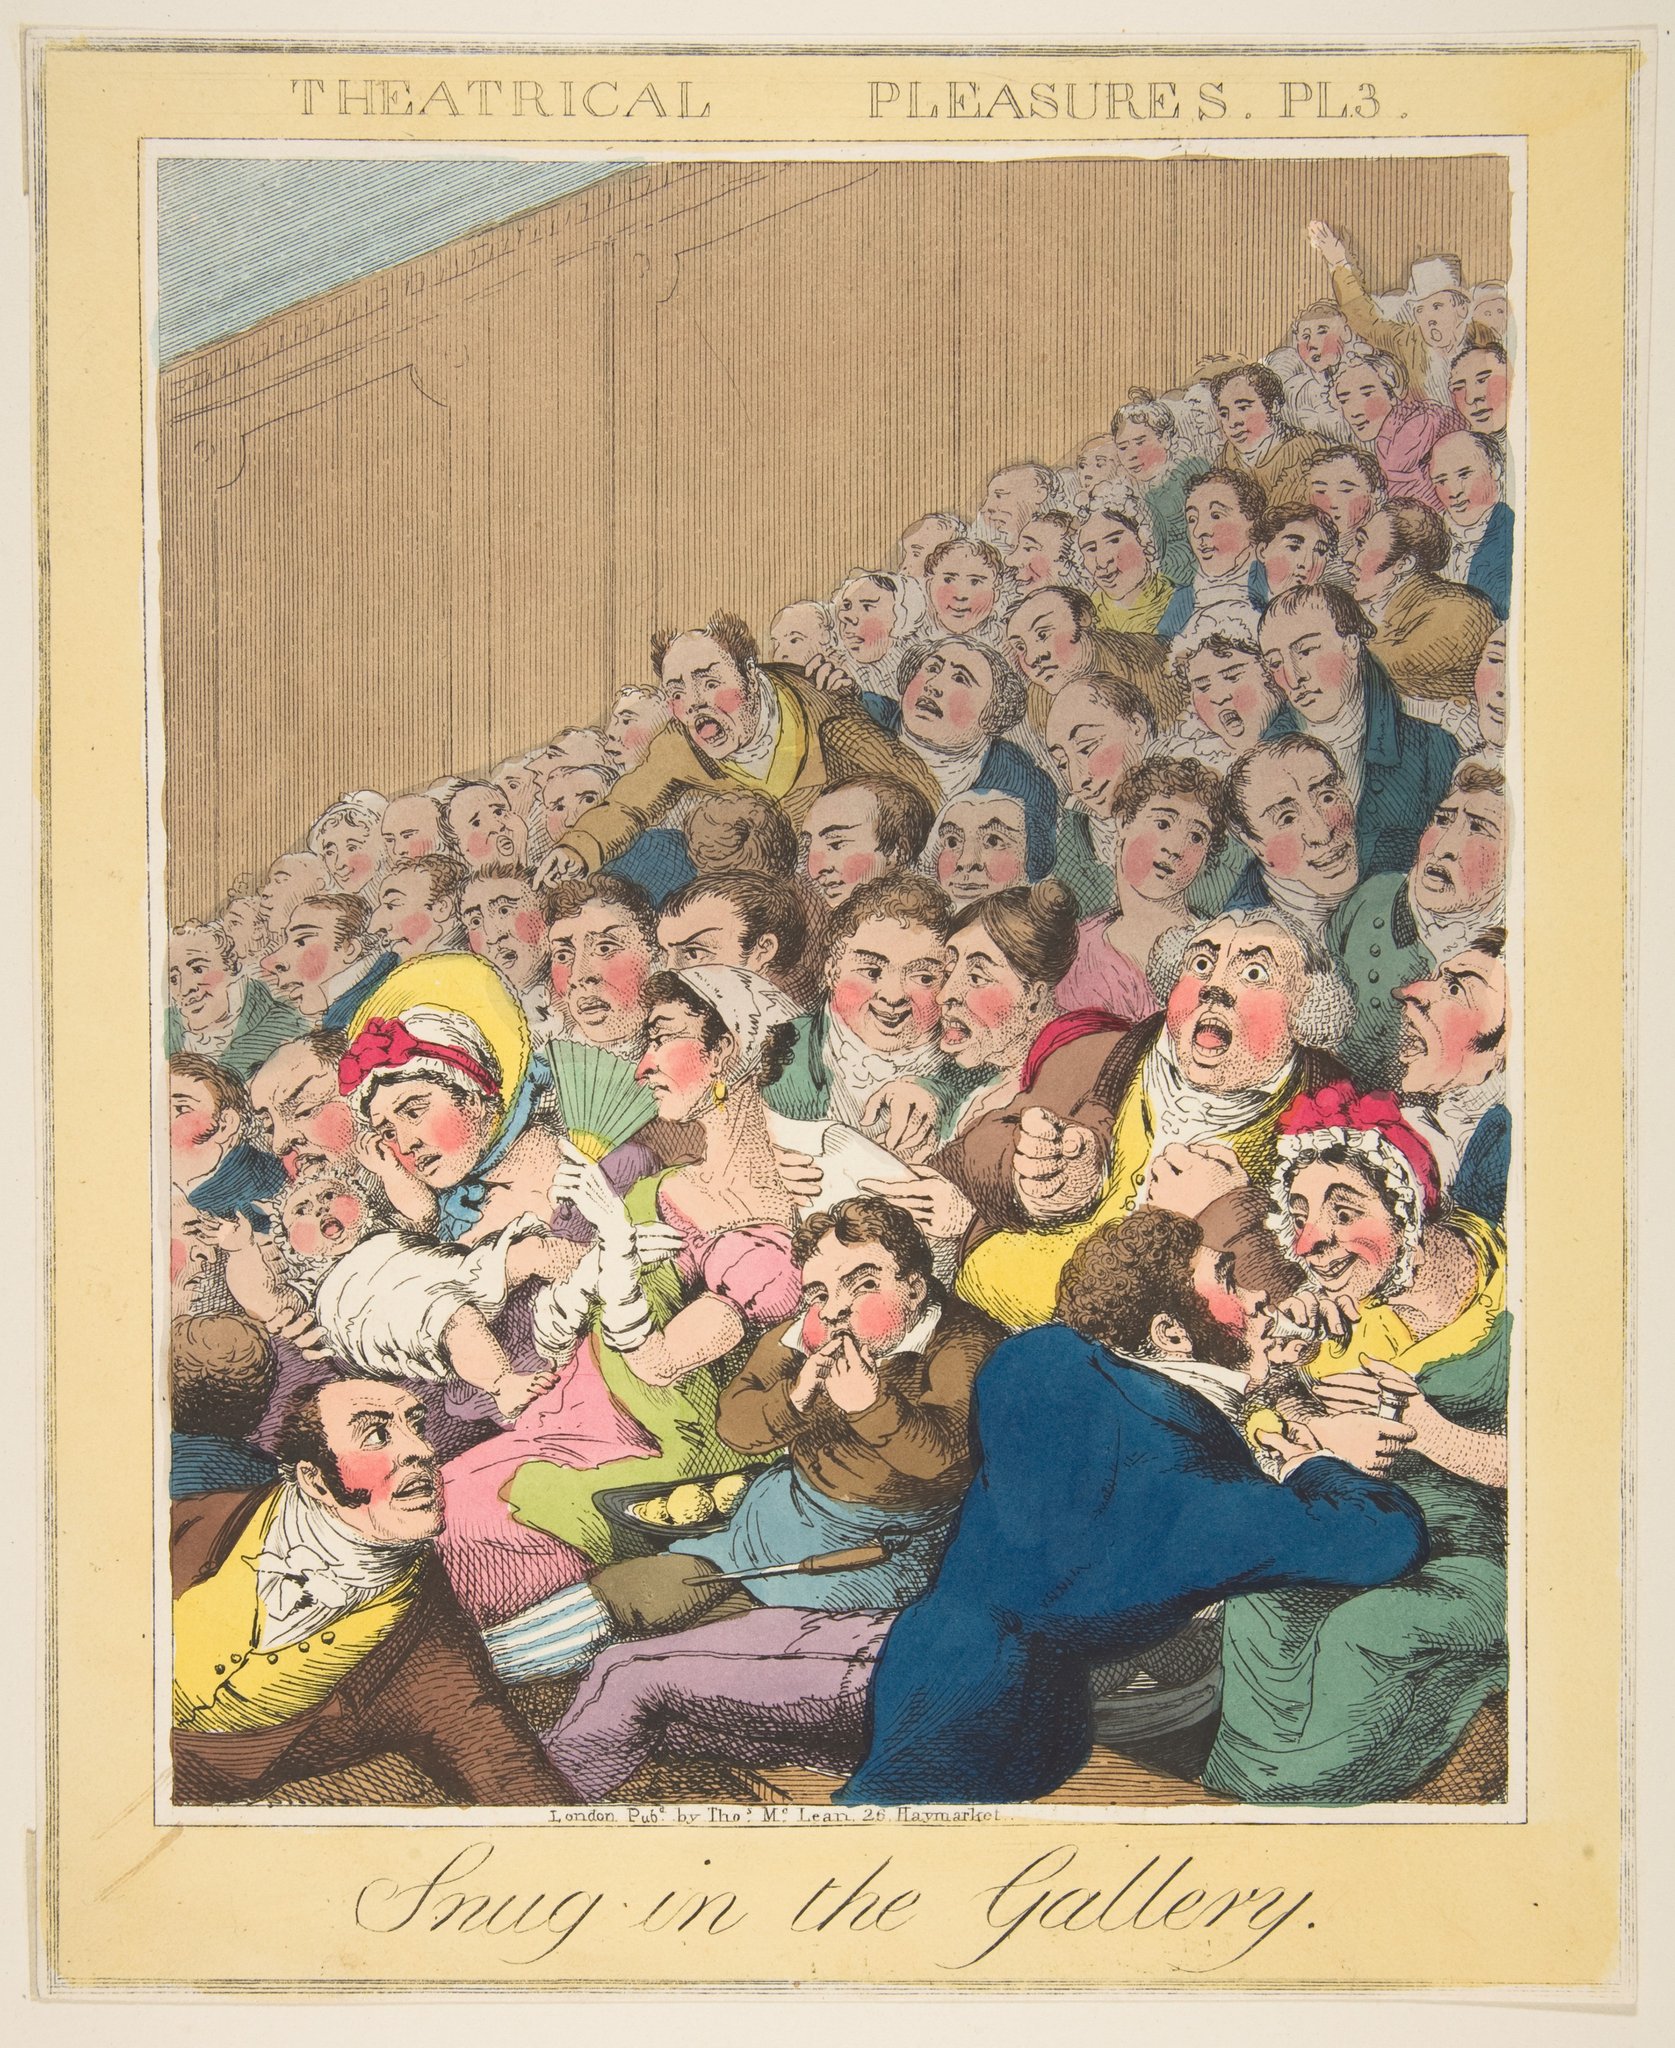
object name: print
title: Theatrical Pleasures, ( Snug in the Gallery, Plate 3)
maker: theodore lane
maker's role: artist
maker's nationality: british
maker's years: 1800-1828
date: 1835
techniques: etching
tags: men,women,crowd